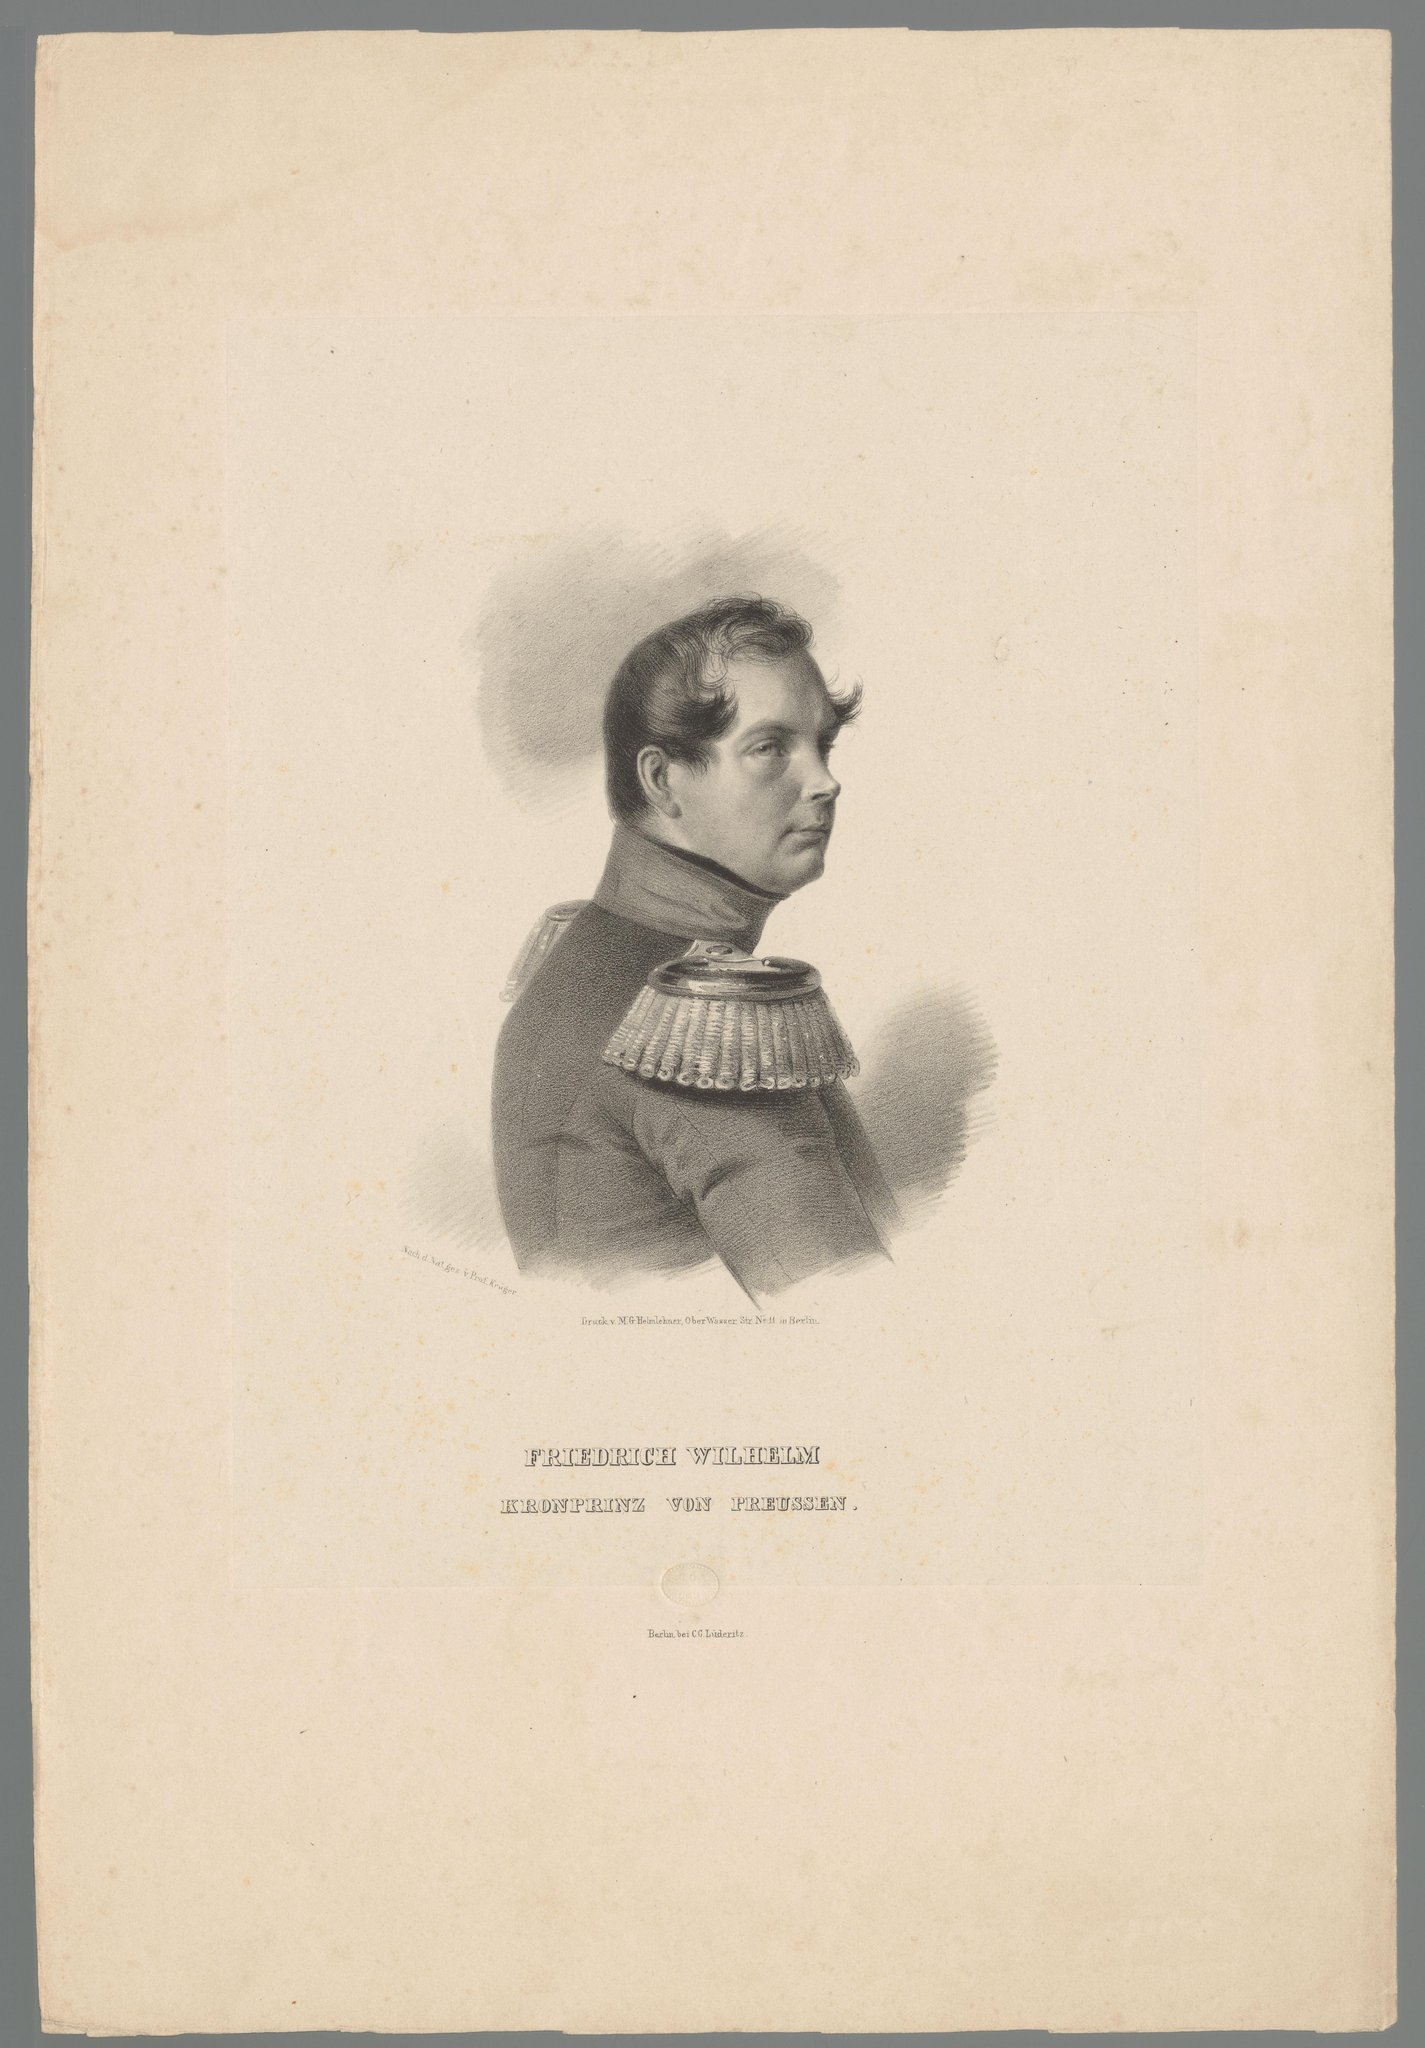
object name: print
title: Portret van Frederik Willem IV, koning van Pruisen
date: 1813-1837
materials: paper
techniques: lithograph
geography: berlin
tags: berlin, frederik willem iv (koning van pruisen), historical persons, crown prince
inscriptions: collector's mark: Lugt 2228, check stamp: Lugt 4519